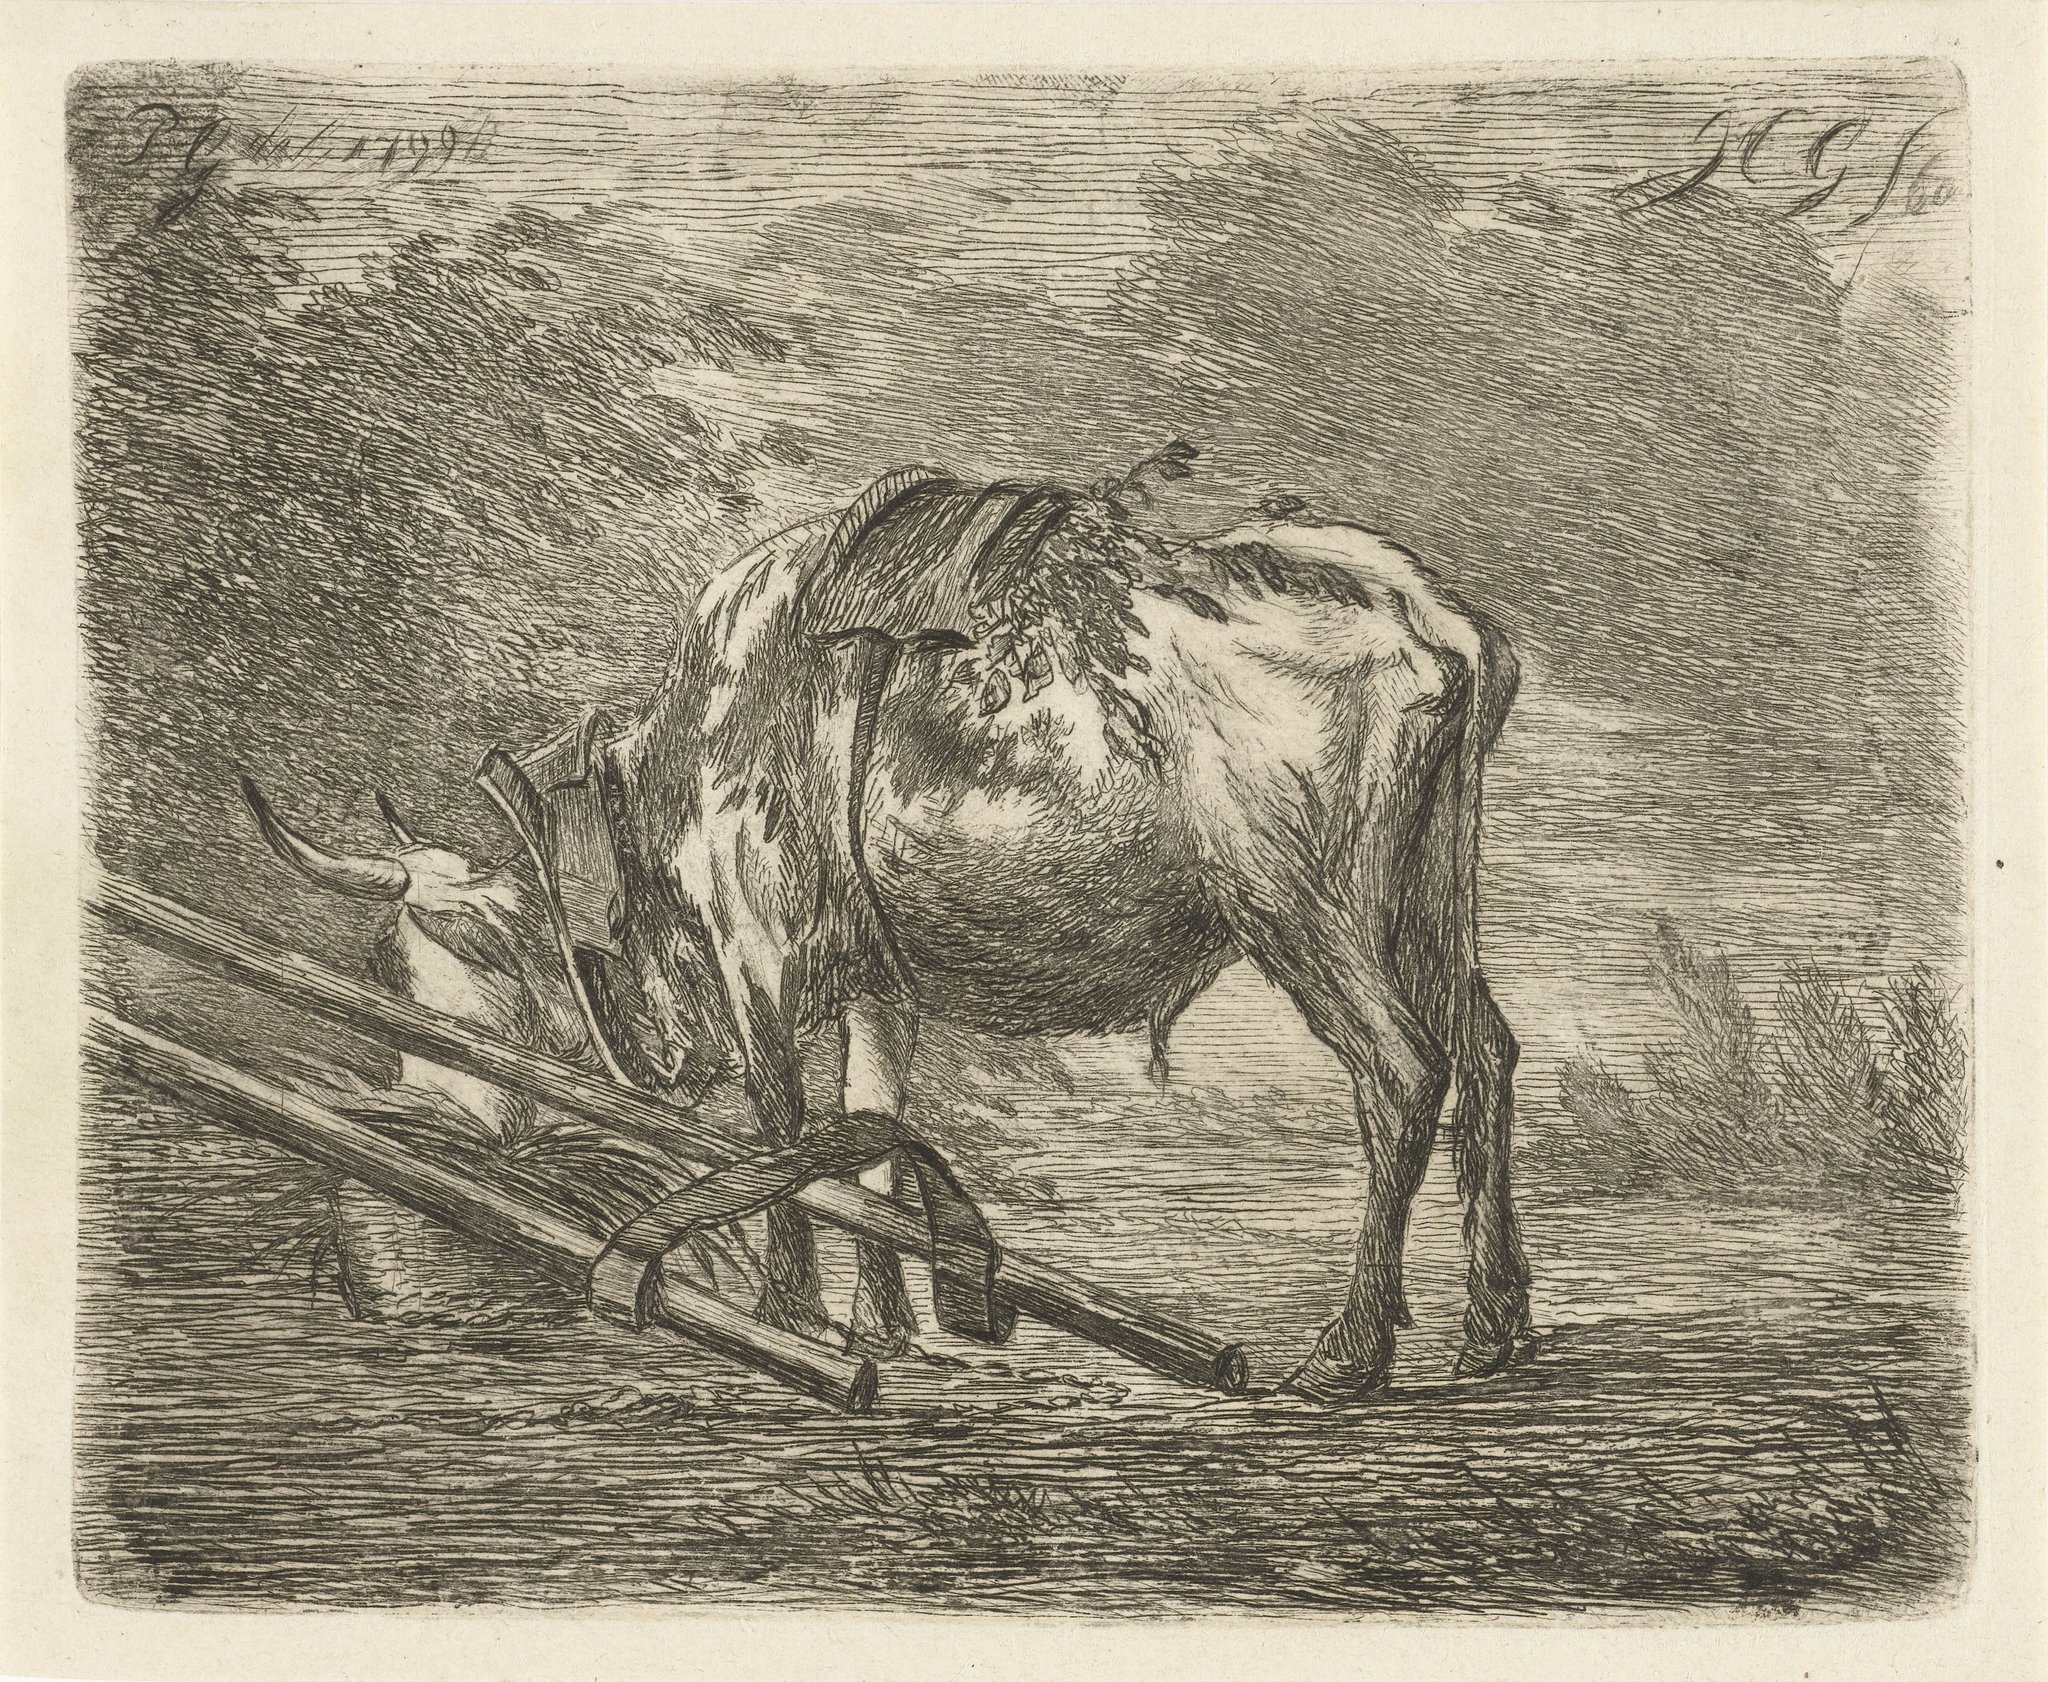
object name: print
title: Trekos met juk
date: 1860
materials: paper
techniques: etching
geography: netherlands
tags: ox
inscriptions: collector's mark: Lugt 2228